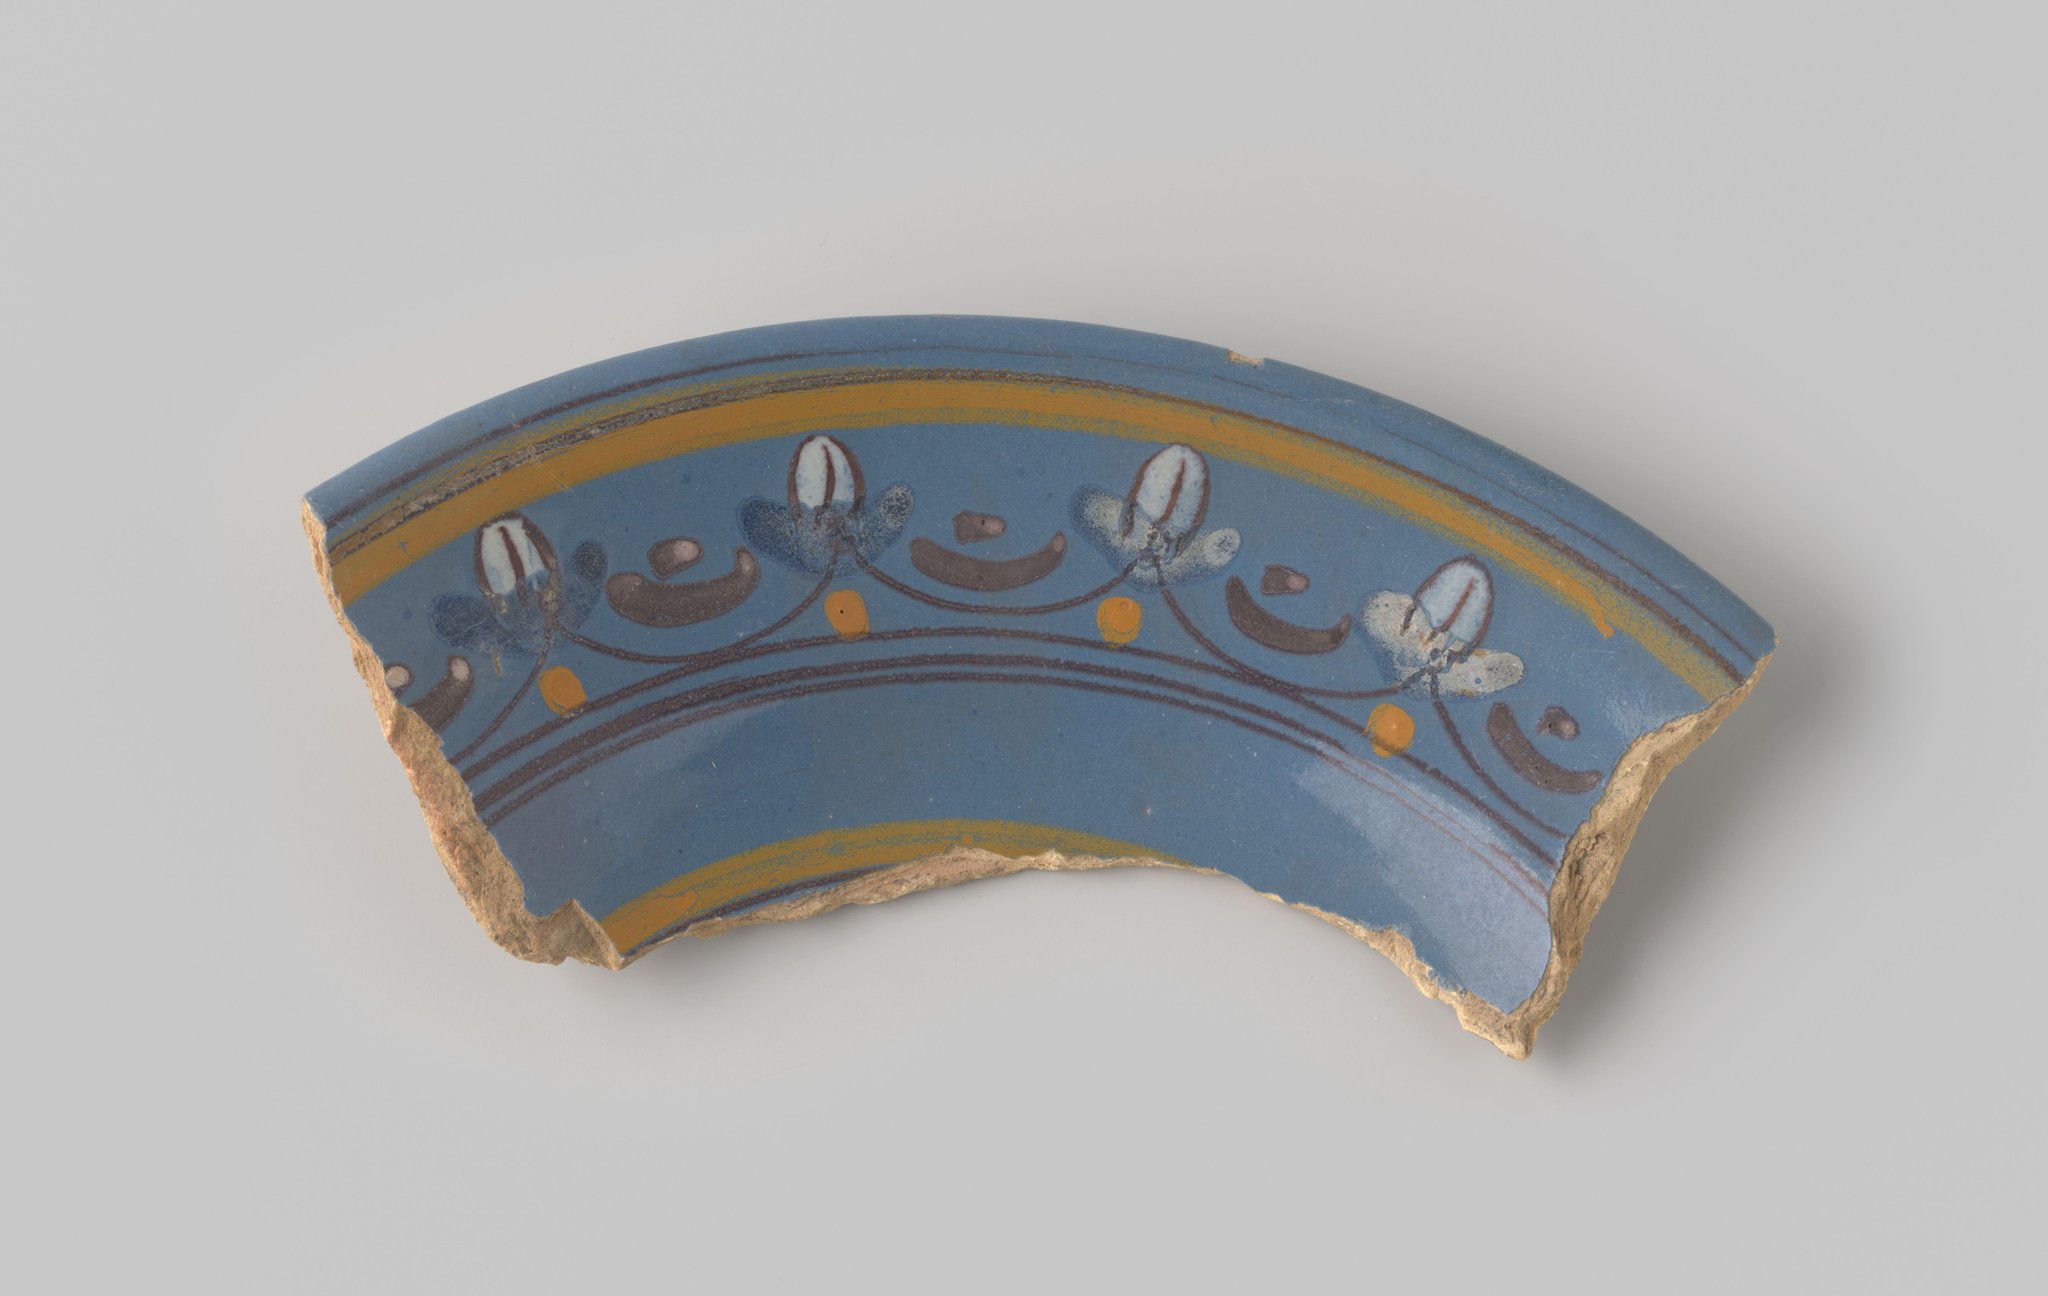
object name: fragment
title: Scherf van rossigbakkend aardewerk, aan de bovenzijde voorzien van blauw glazuur met een met halve cirkels en stippen beschilderde rand in geel, bruin, oranje en wit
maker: Anonymous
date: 1600-1650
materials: earthenware, glaze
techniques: maiolica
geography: northern netherlands